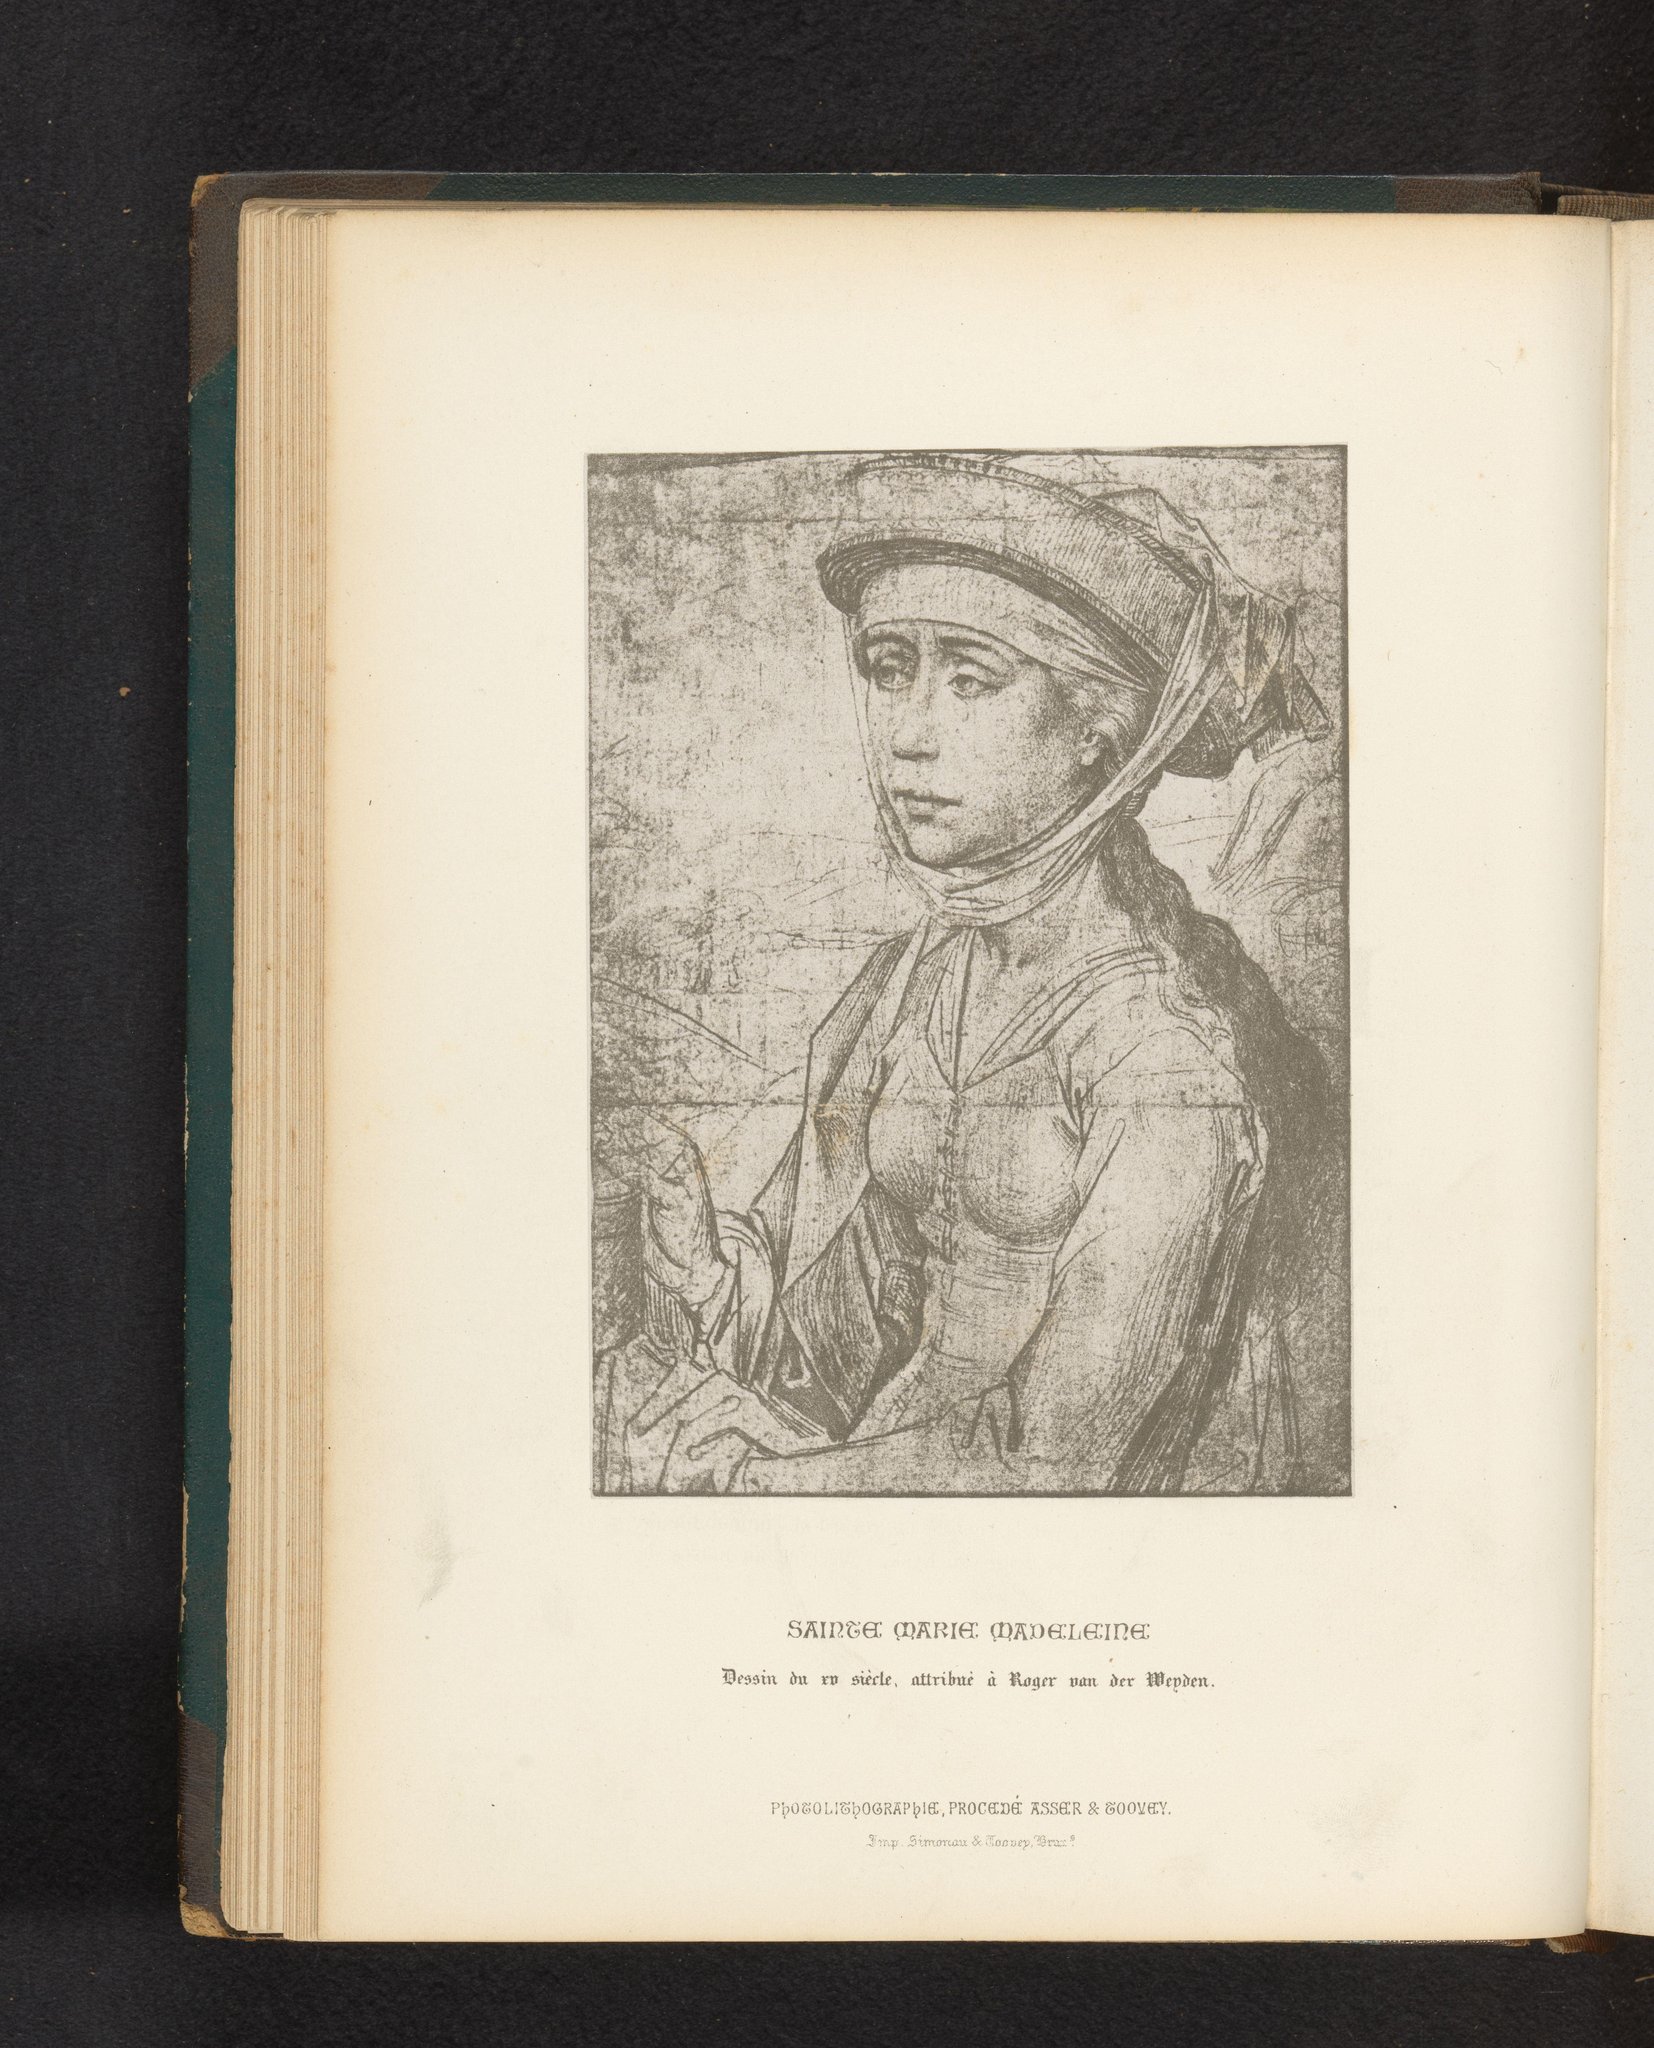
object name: reproduction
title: Reproductie van een tekening van Maria Magdalena door Rogier van der Weyden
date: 1858-1863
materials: paper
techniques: photolithography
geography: brussels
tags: the penitent harlot mary magdalene; possible attributes: book (or scroll), crown, crown of thorns, crucifix, jar of ointment, mirror, musical instrument, palm-branch, rosary, scourge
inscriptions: inscription: ‘Dessin du XV siècle, attribué à Roger van der Weyden.’